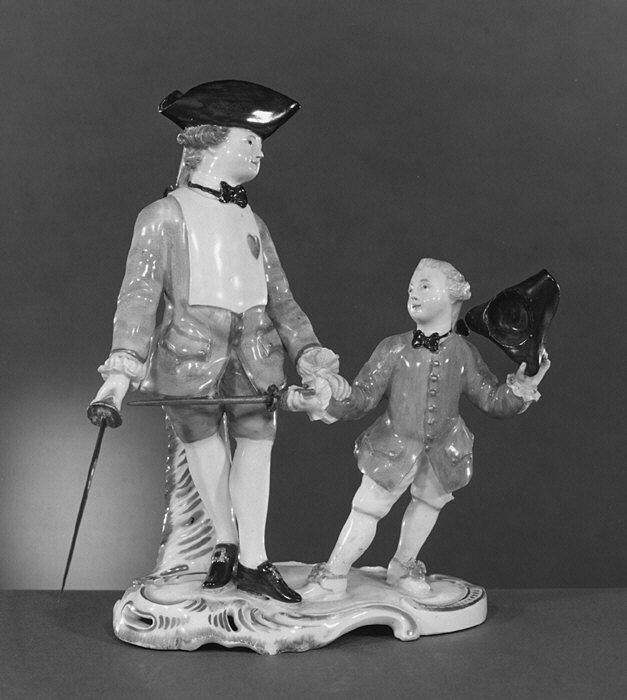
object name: group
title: The Fencing Lesson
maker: höchst manufactory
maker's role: manufactory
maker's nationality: german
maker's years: 1746-1796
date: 1755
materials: hard paste porcelain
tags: boys,men